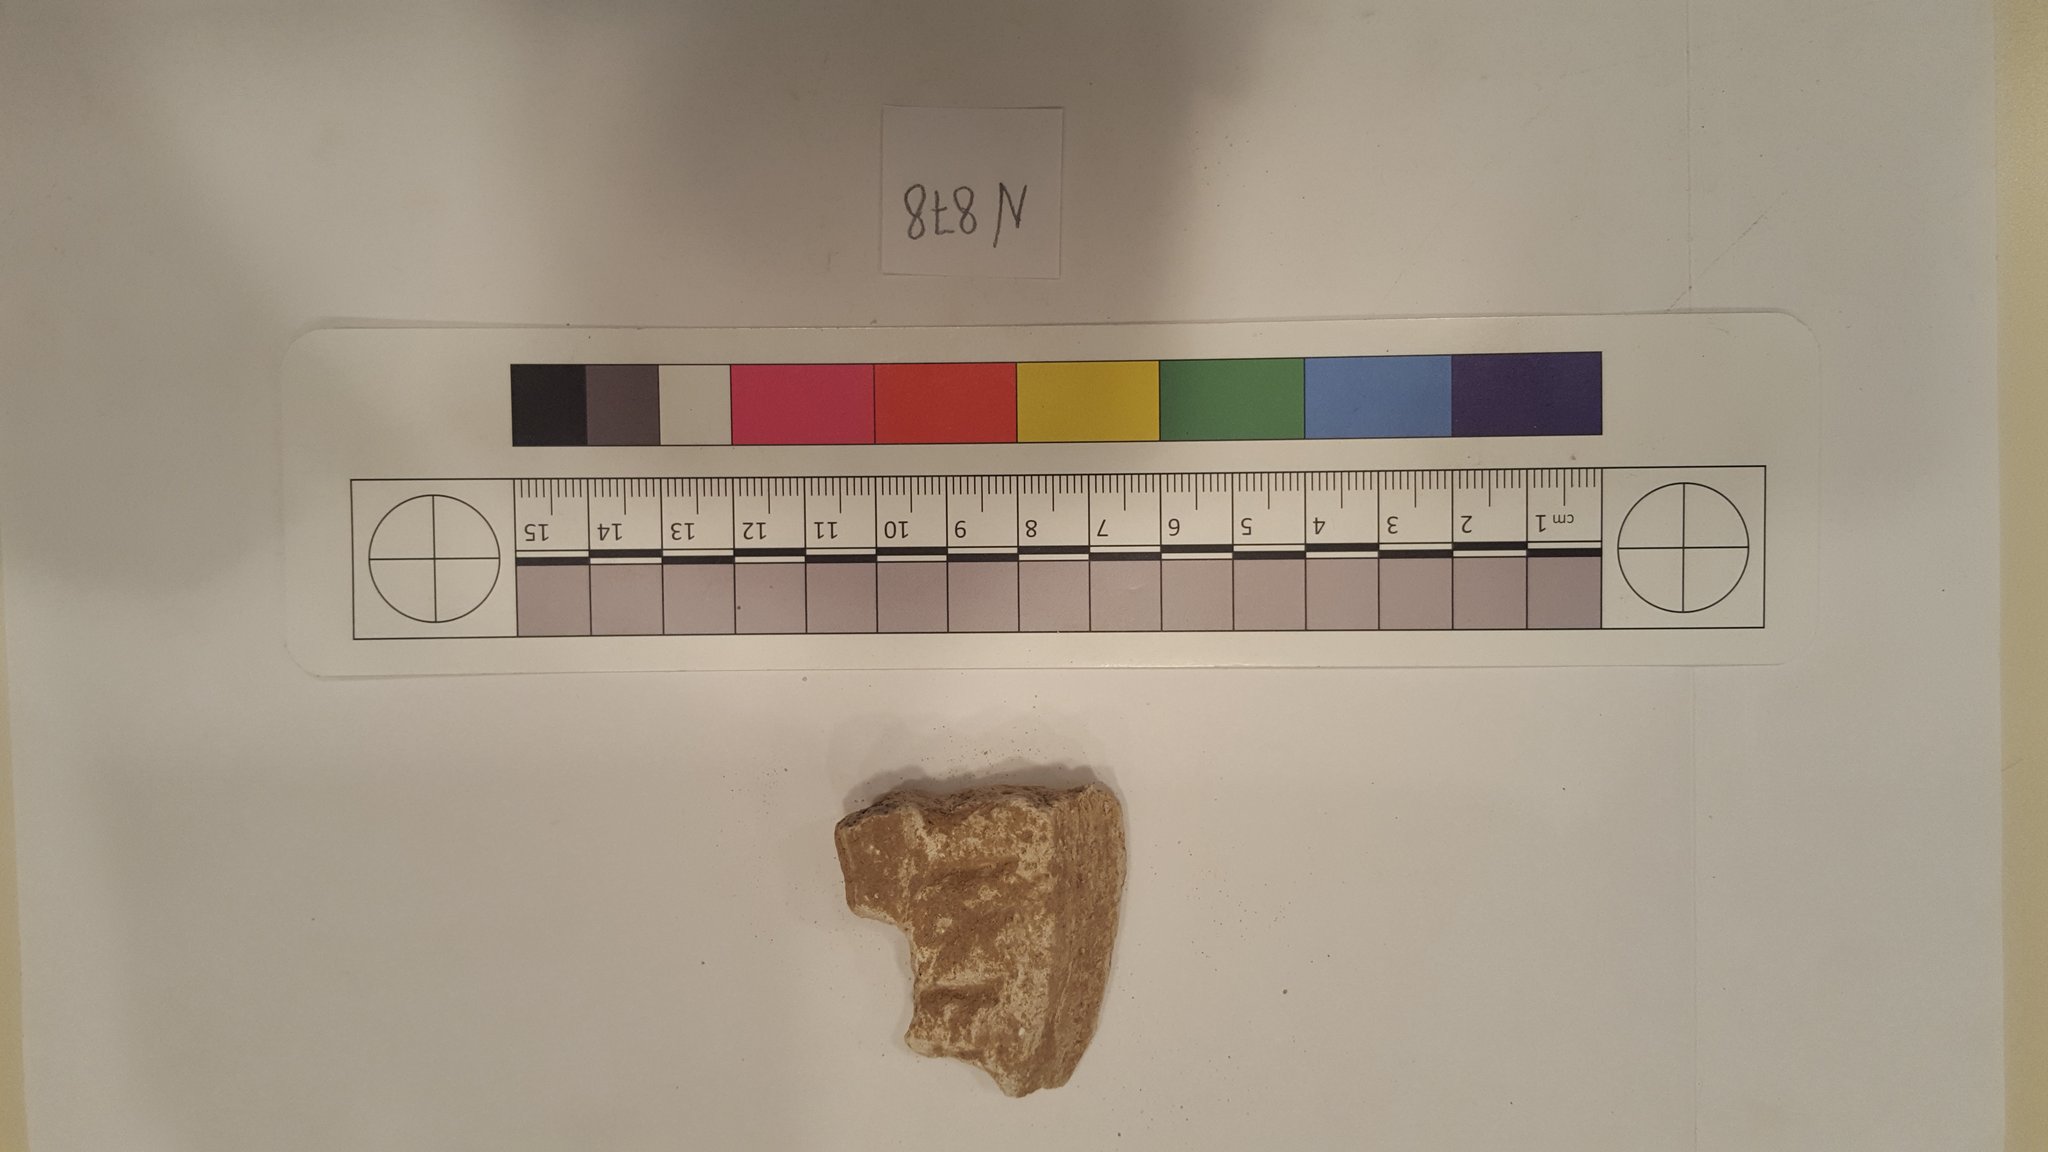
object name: fragment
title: Stucco Fragment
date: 701-1200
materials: plaster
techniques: carving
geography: iran